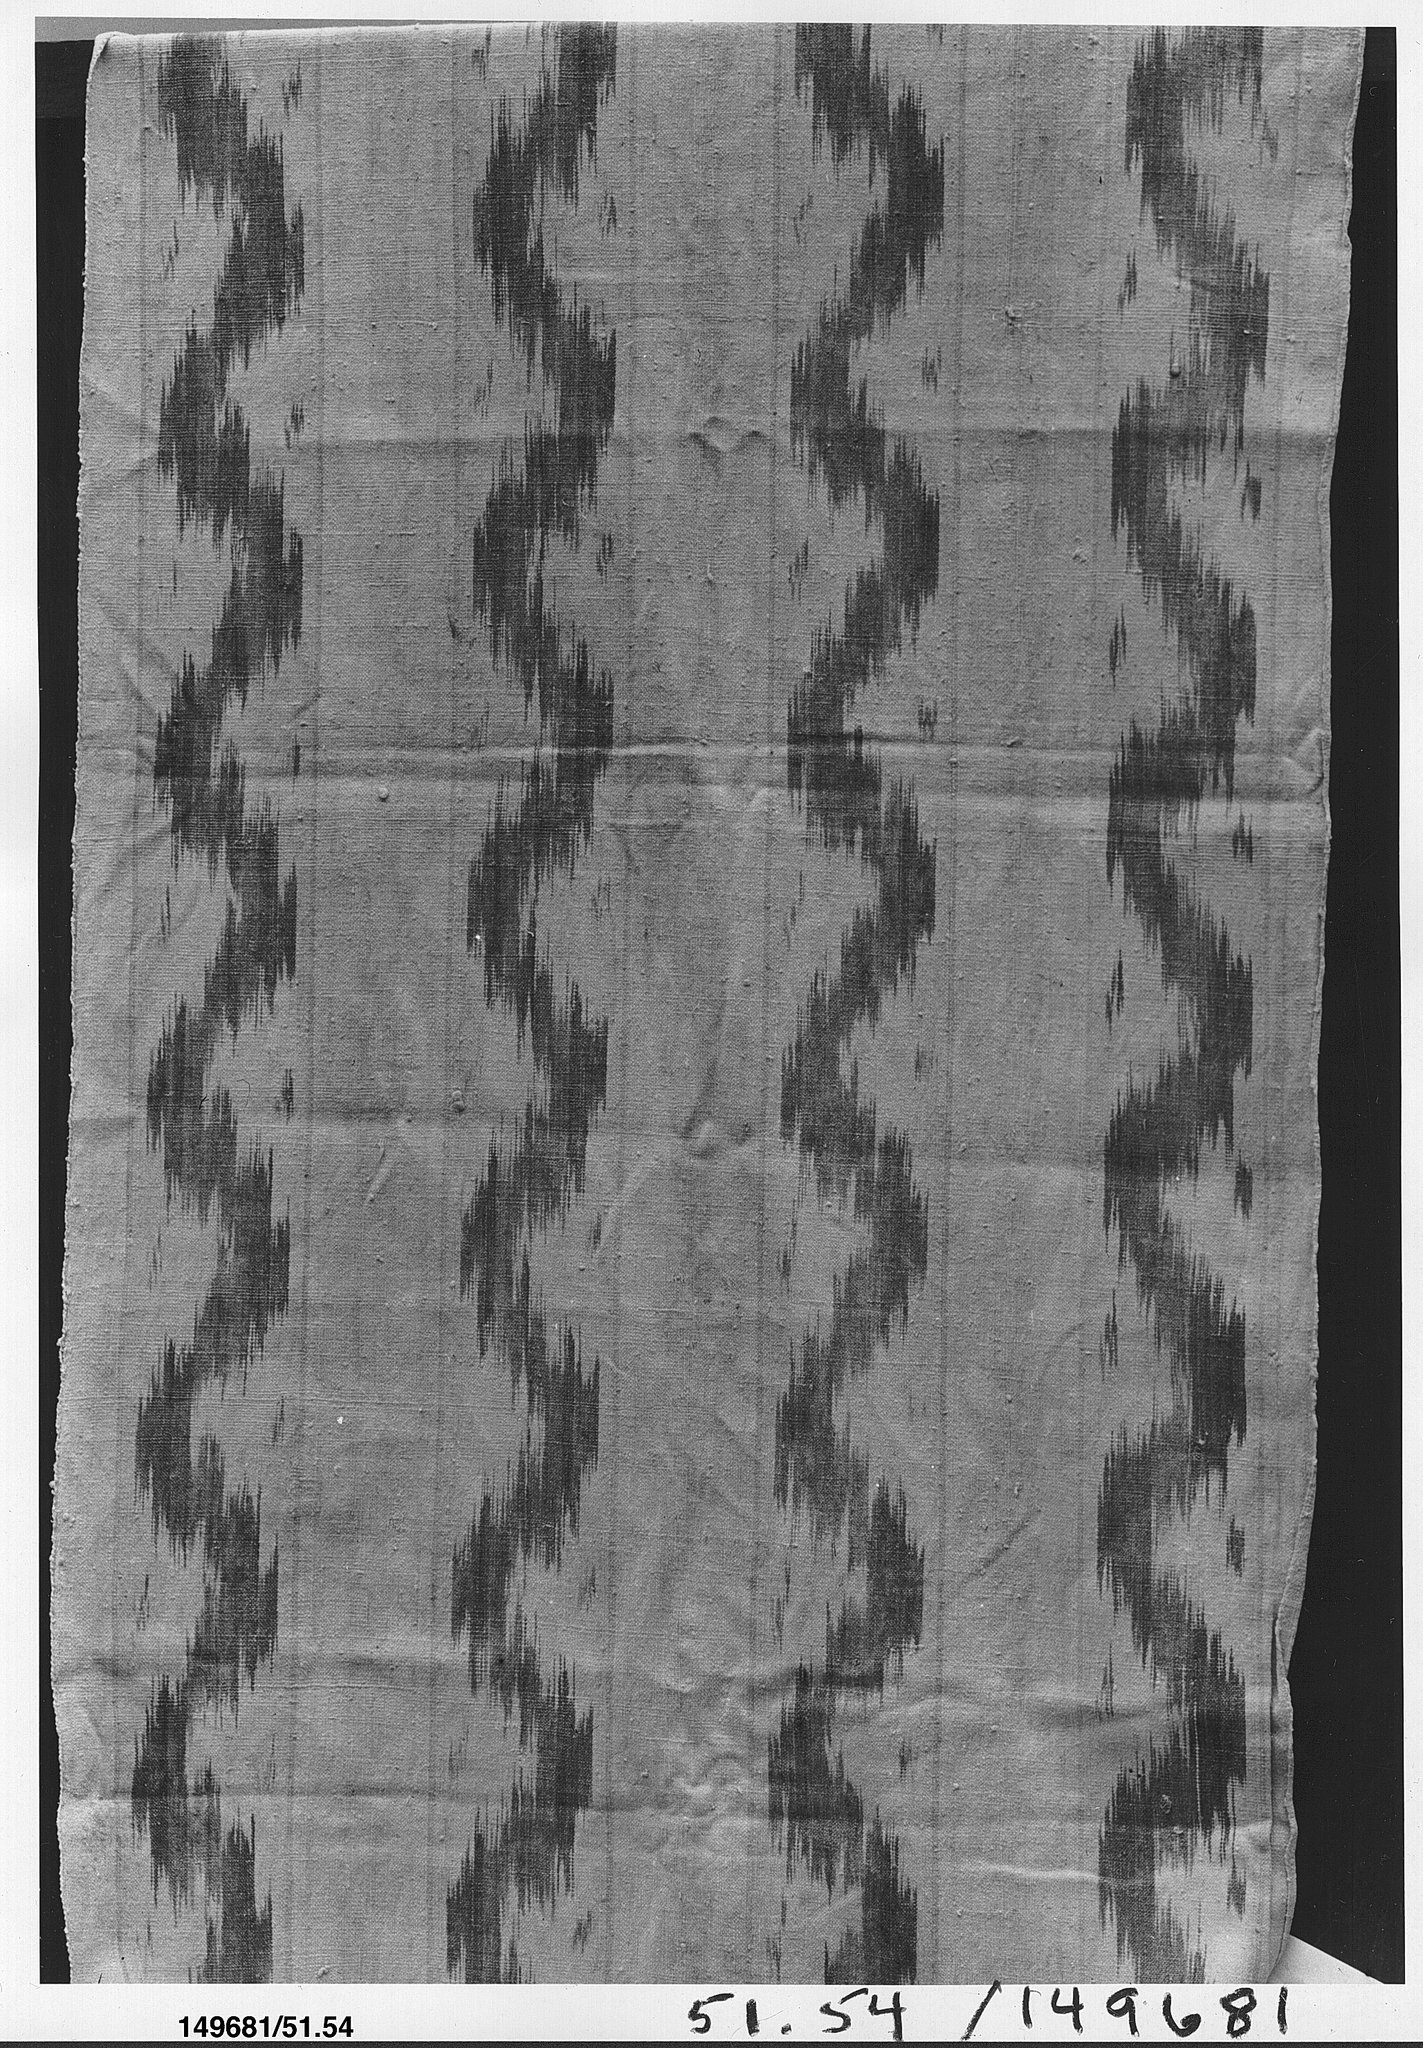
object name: curtain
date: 1701-1800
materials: cotton